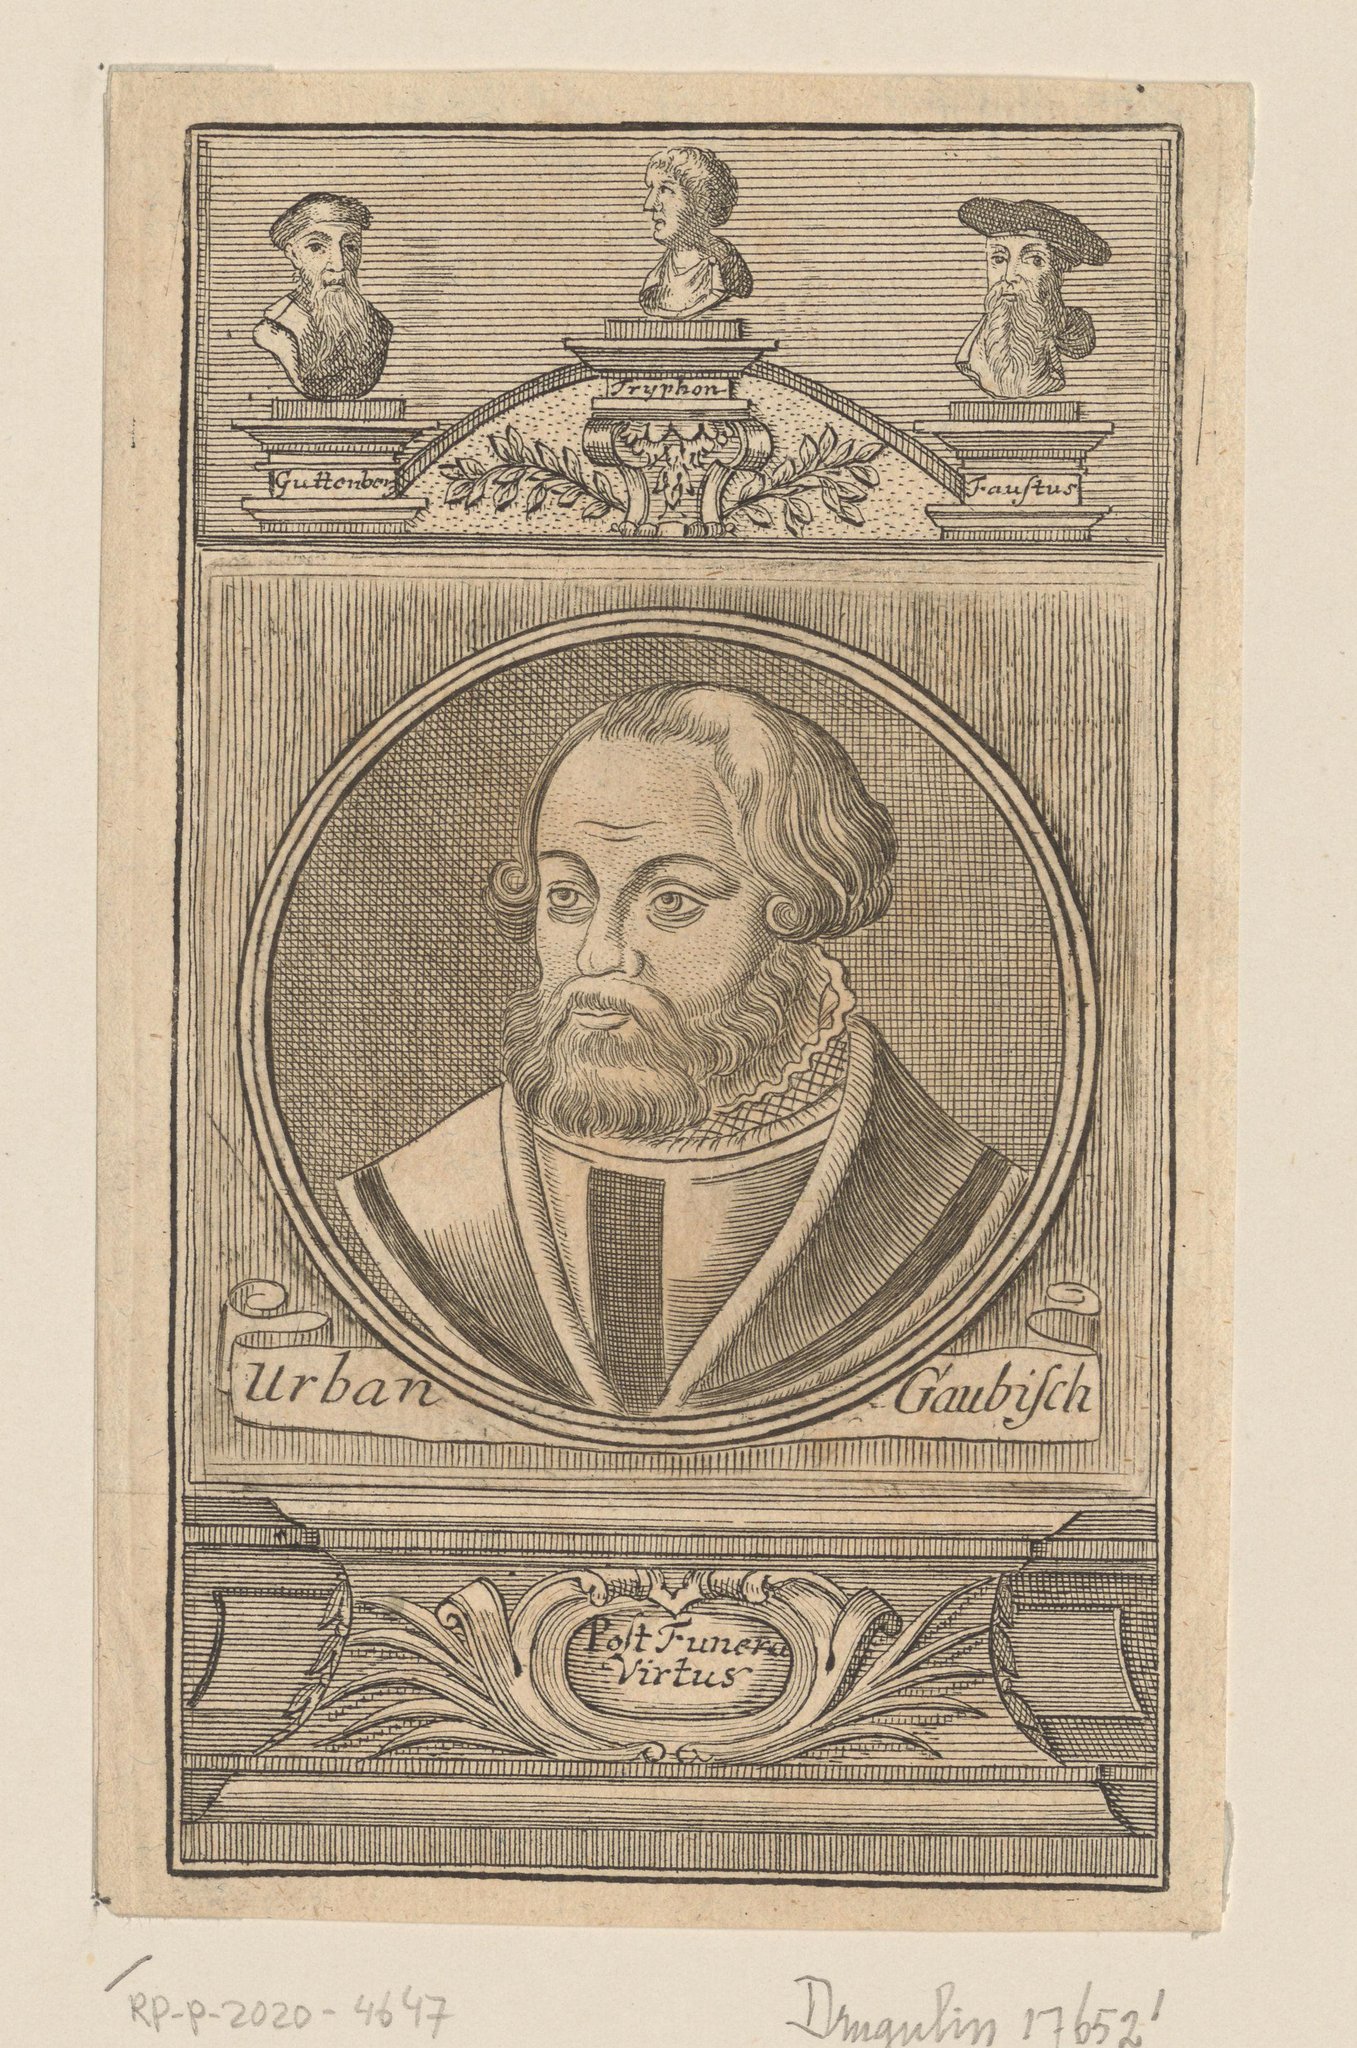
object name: print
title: Portret van Urban Gaubisch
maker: Anonymous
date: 1600-1700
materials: paper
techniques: engraving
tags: printer, publisher, urban gaubisch, publishing, publisher (+ portrait of scholar, scientist), historical persons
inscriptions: watermark